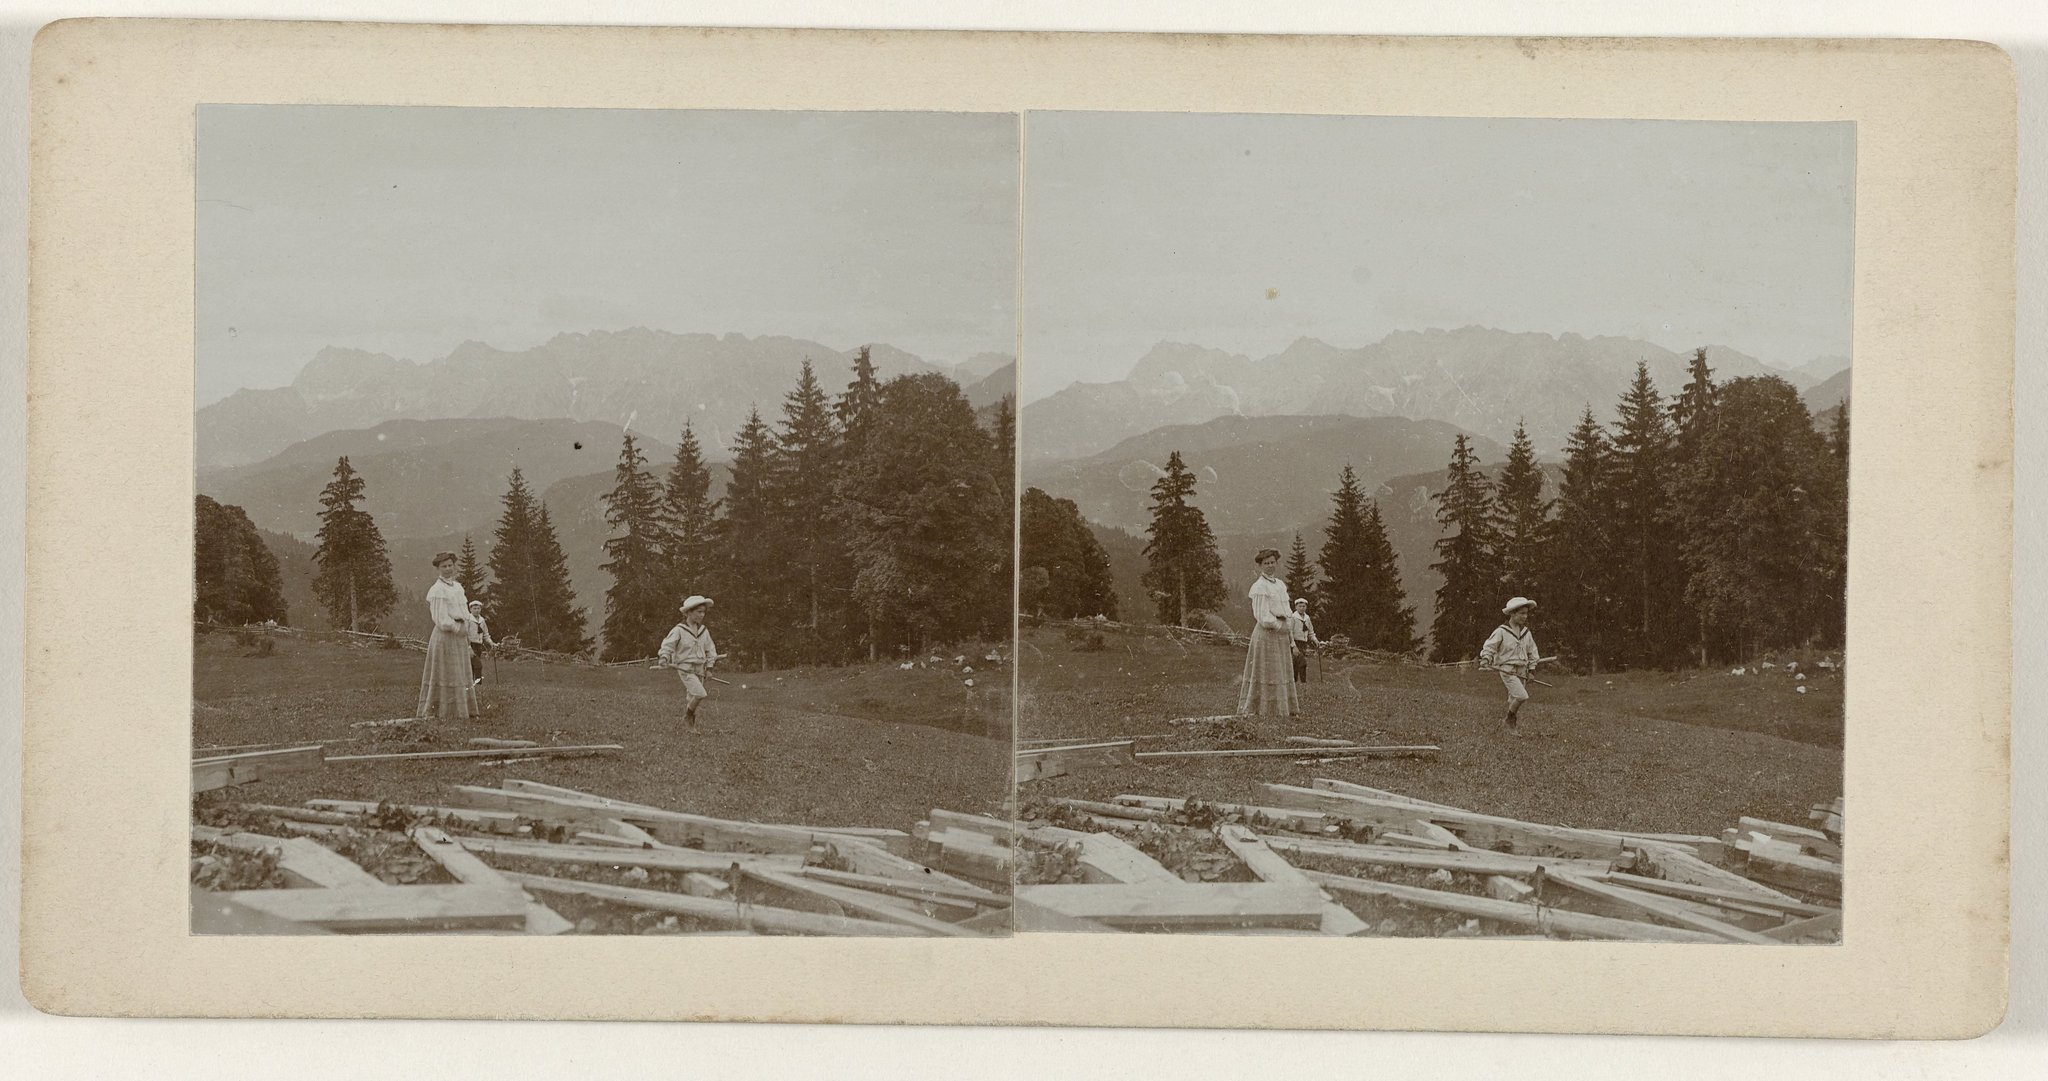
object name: stereograph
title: Mevrouw Kessler-de Lange en twee kinderen spelend in een veld te Garmisch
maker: geldolph adriaan kessler (dolph)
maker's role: fotograaf, industrieel, voetballer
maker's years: 1884-1945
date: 1906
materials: paper, photographic support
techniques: collodion silver print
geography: gelderland